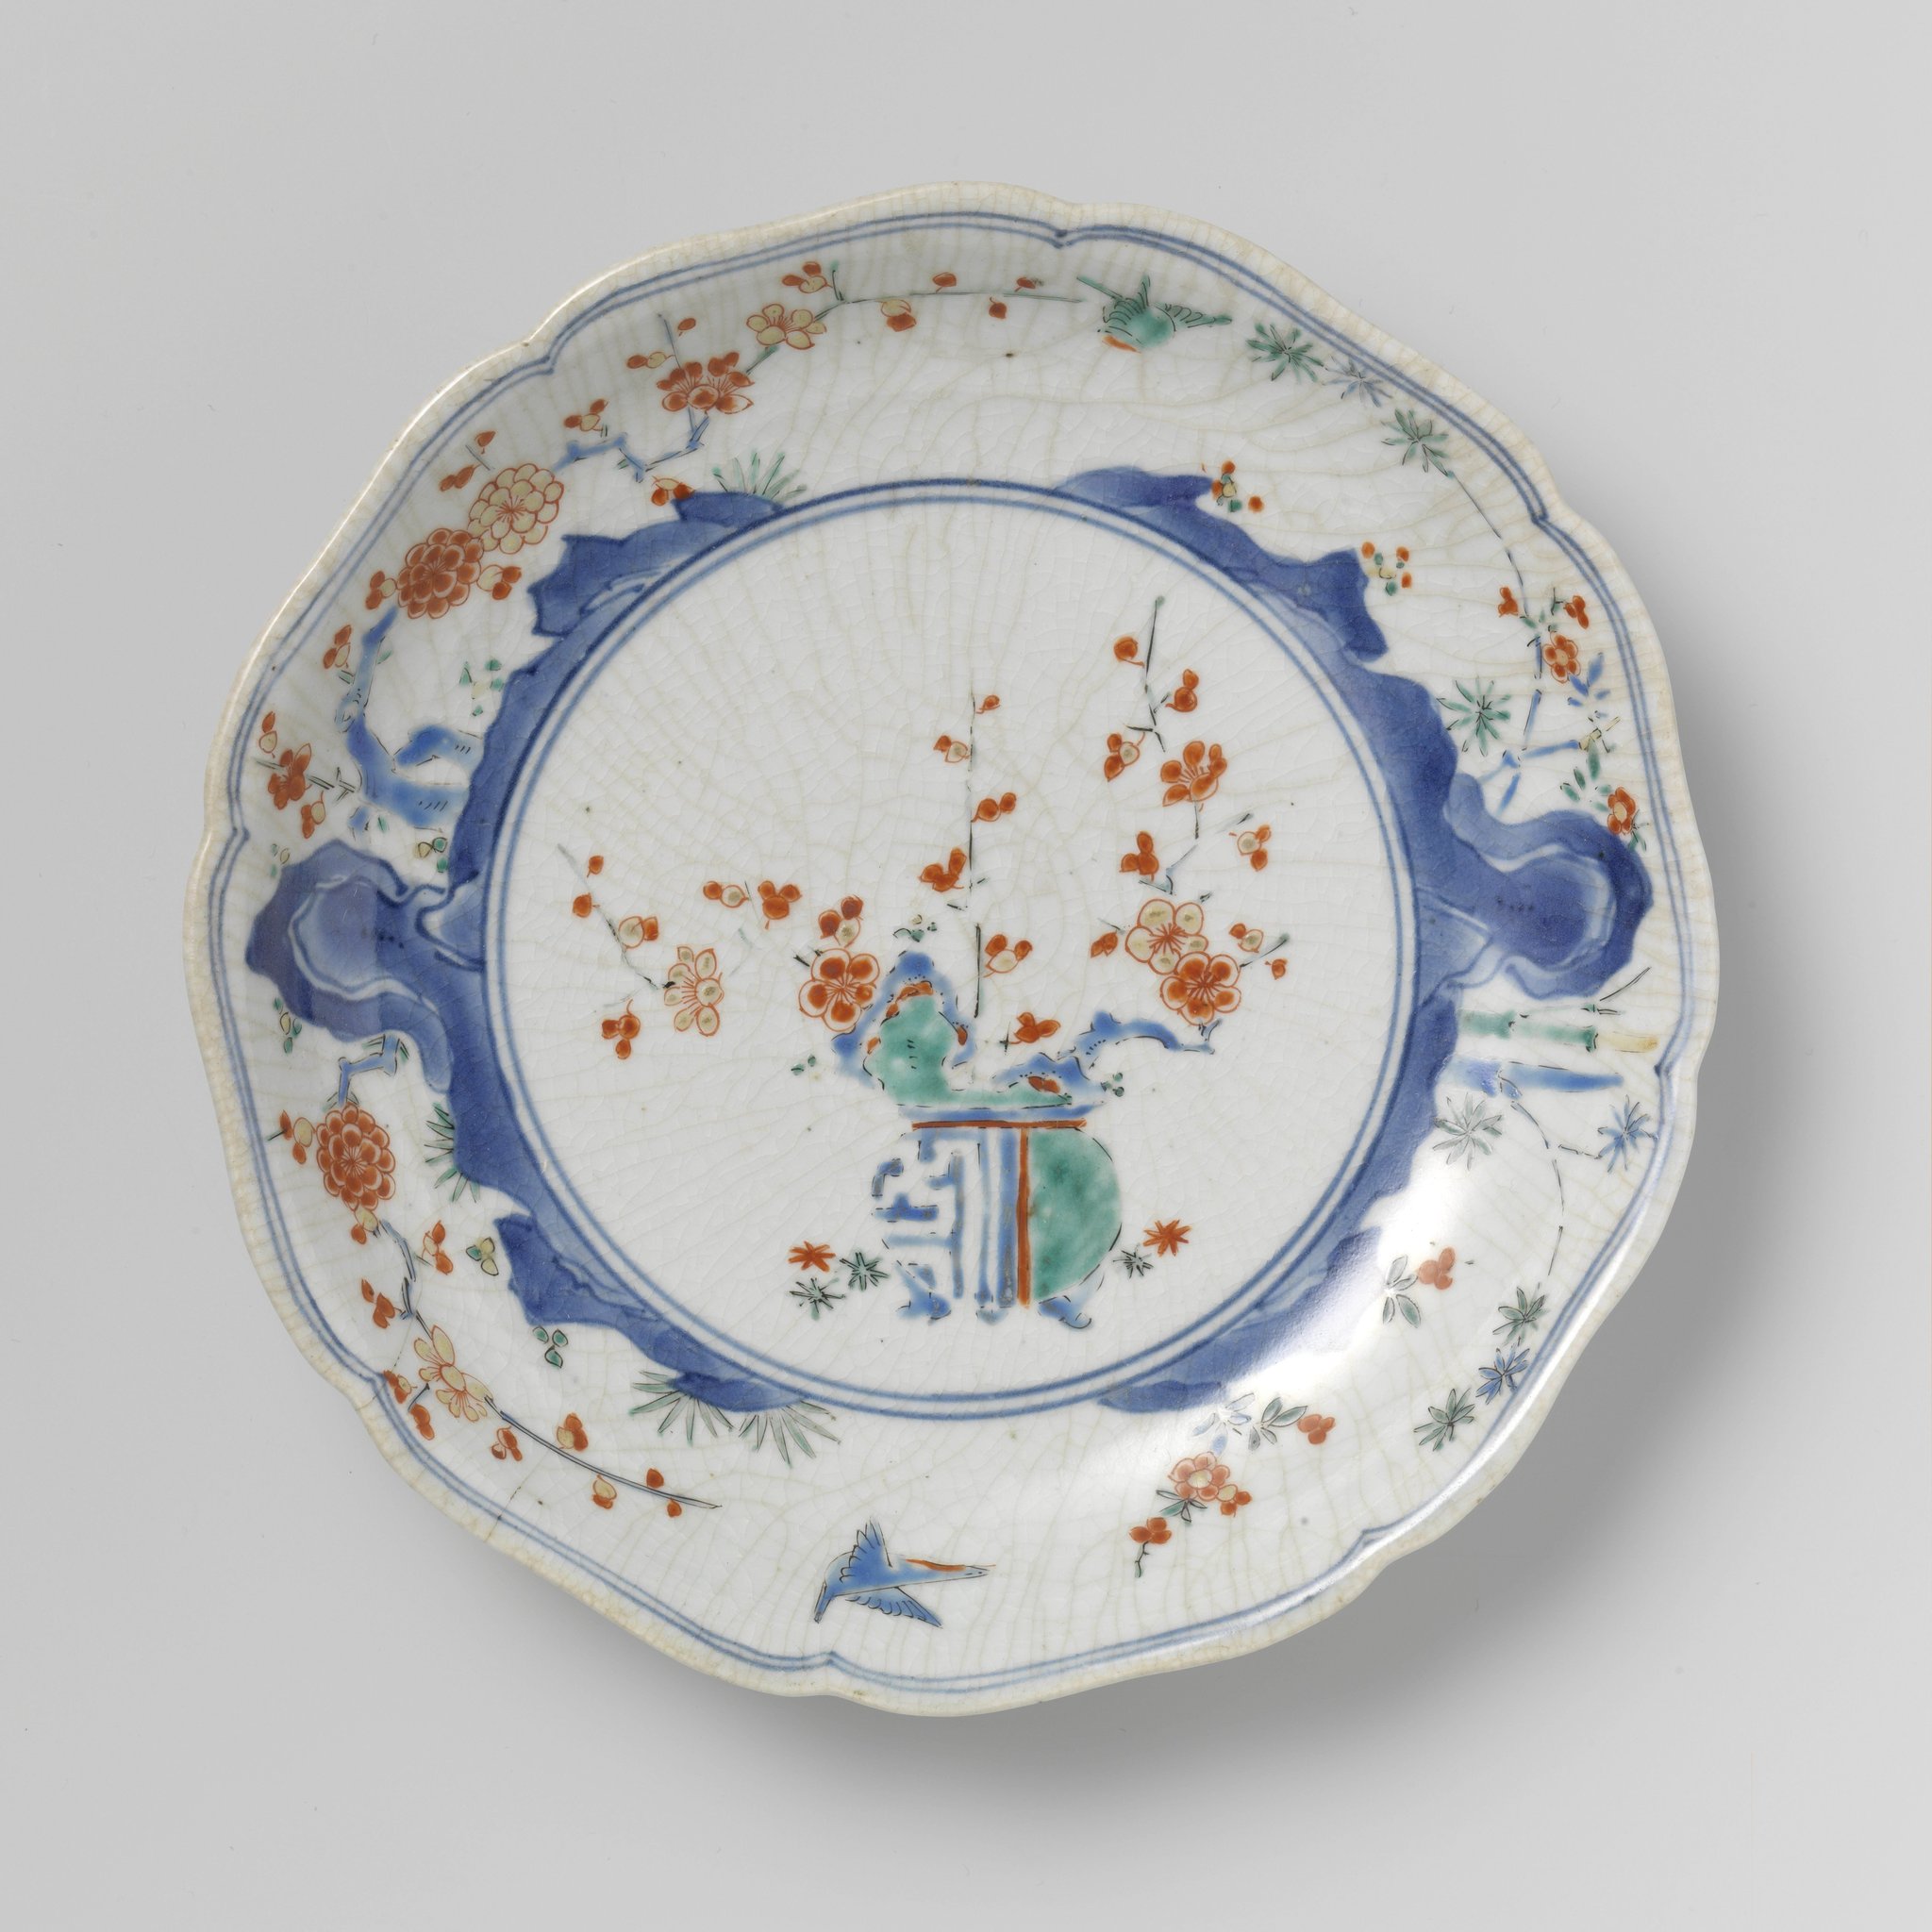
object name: plate dish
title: Scalloped dish with flowerpot, rocks, birds, bamboo and prunus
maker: Anonymous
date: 1670-1700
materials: cobalt, glaze, paint, porcelain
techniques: firing, turning, vitrification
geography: arita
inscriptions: label: ‘Collectie Westendorp/ 8’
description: Bord van porselein met geschulpte rand, beschilderd in onderglazuur blauw met rotsen, en op het glazuur in blauw, rood, groen, geel en zwart met op de spiegel een pot met prunus en op de rand twee vogels tussen prunus en bamboe. Rondom de spiegel en langs de rand een dubbele onderglazuurblauwe lijn. Op de achterkant bladranken in onderglazuurblauw. Enkele proen in de voetring. Vuil in glazurbarsten. Oud label op de onderzijde met 'Collectie Westendorp/ 8'. Kakiemon-stijl.